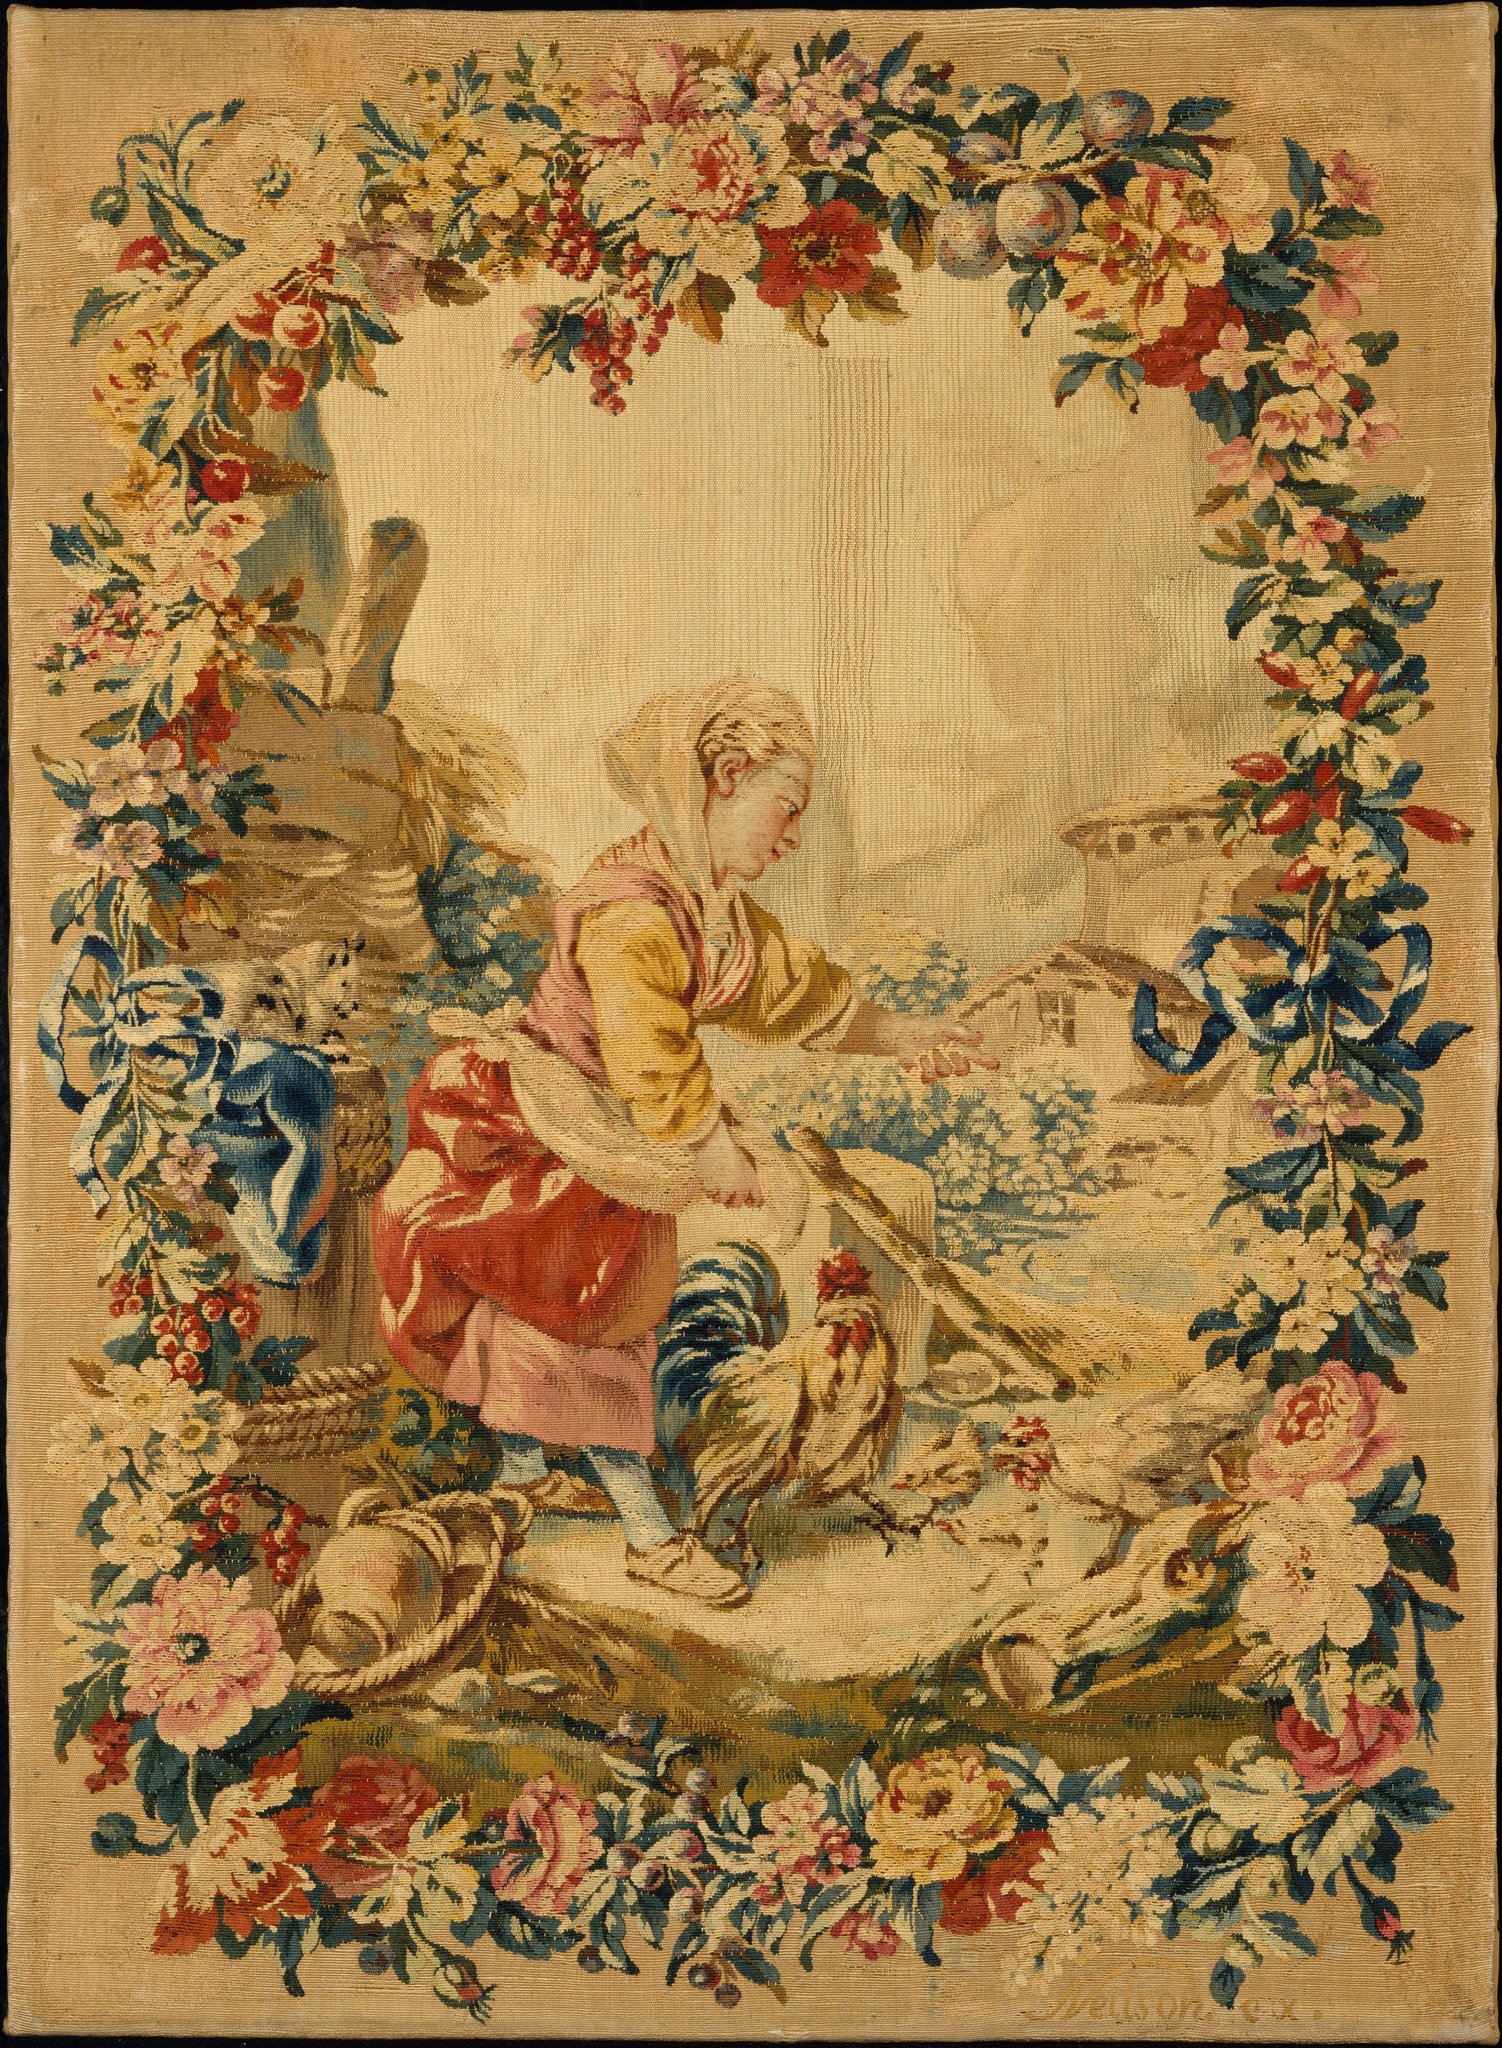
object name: panel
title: Girl Feeding Chickens from the series known as the Enfants de Boucher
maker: françois boucher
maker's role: artist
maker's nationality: french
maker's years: 1703-1770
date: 1770-1780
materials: silk, wool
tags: chickens,girls,flowers